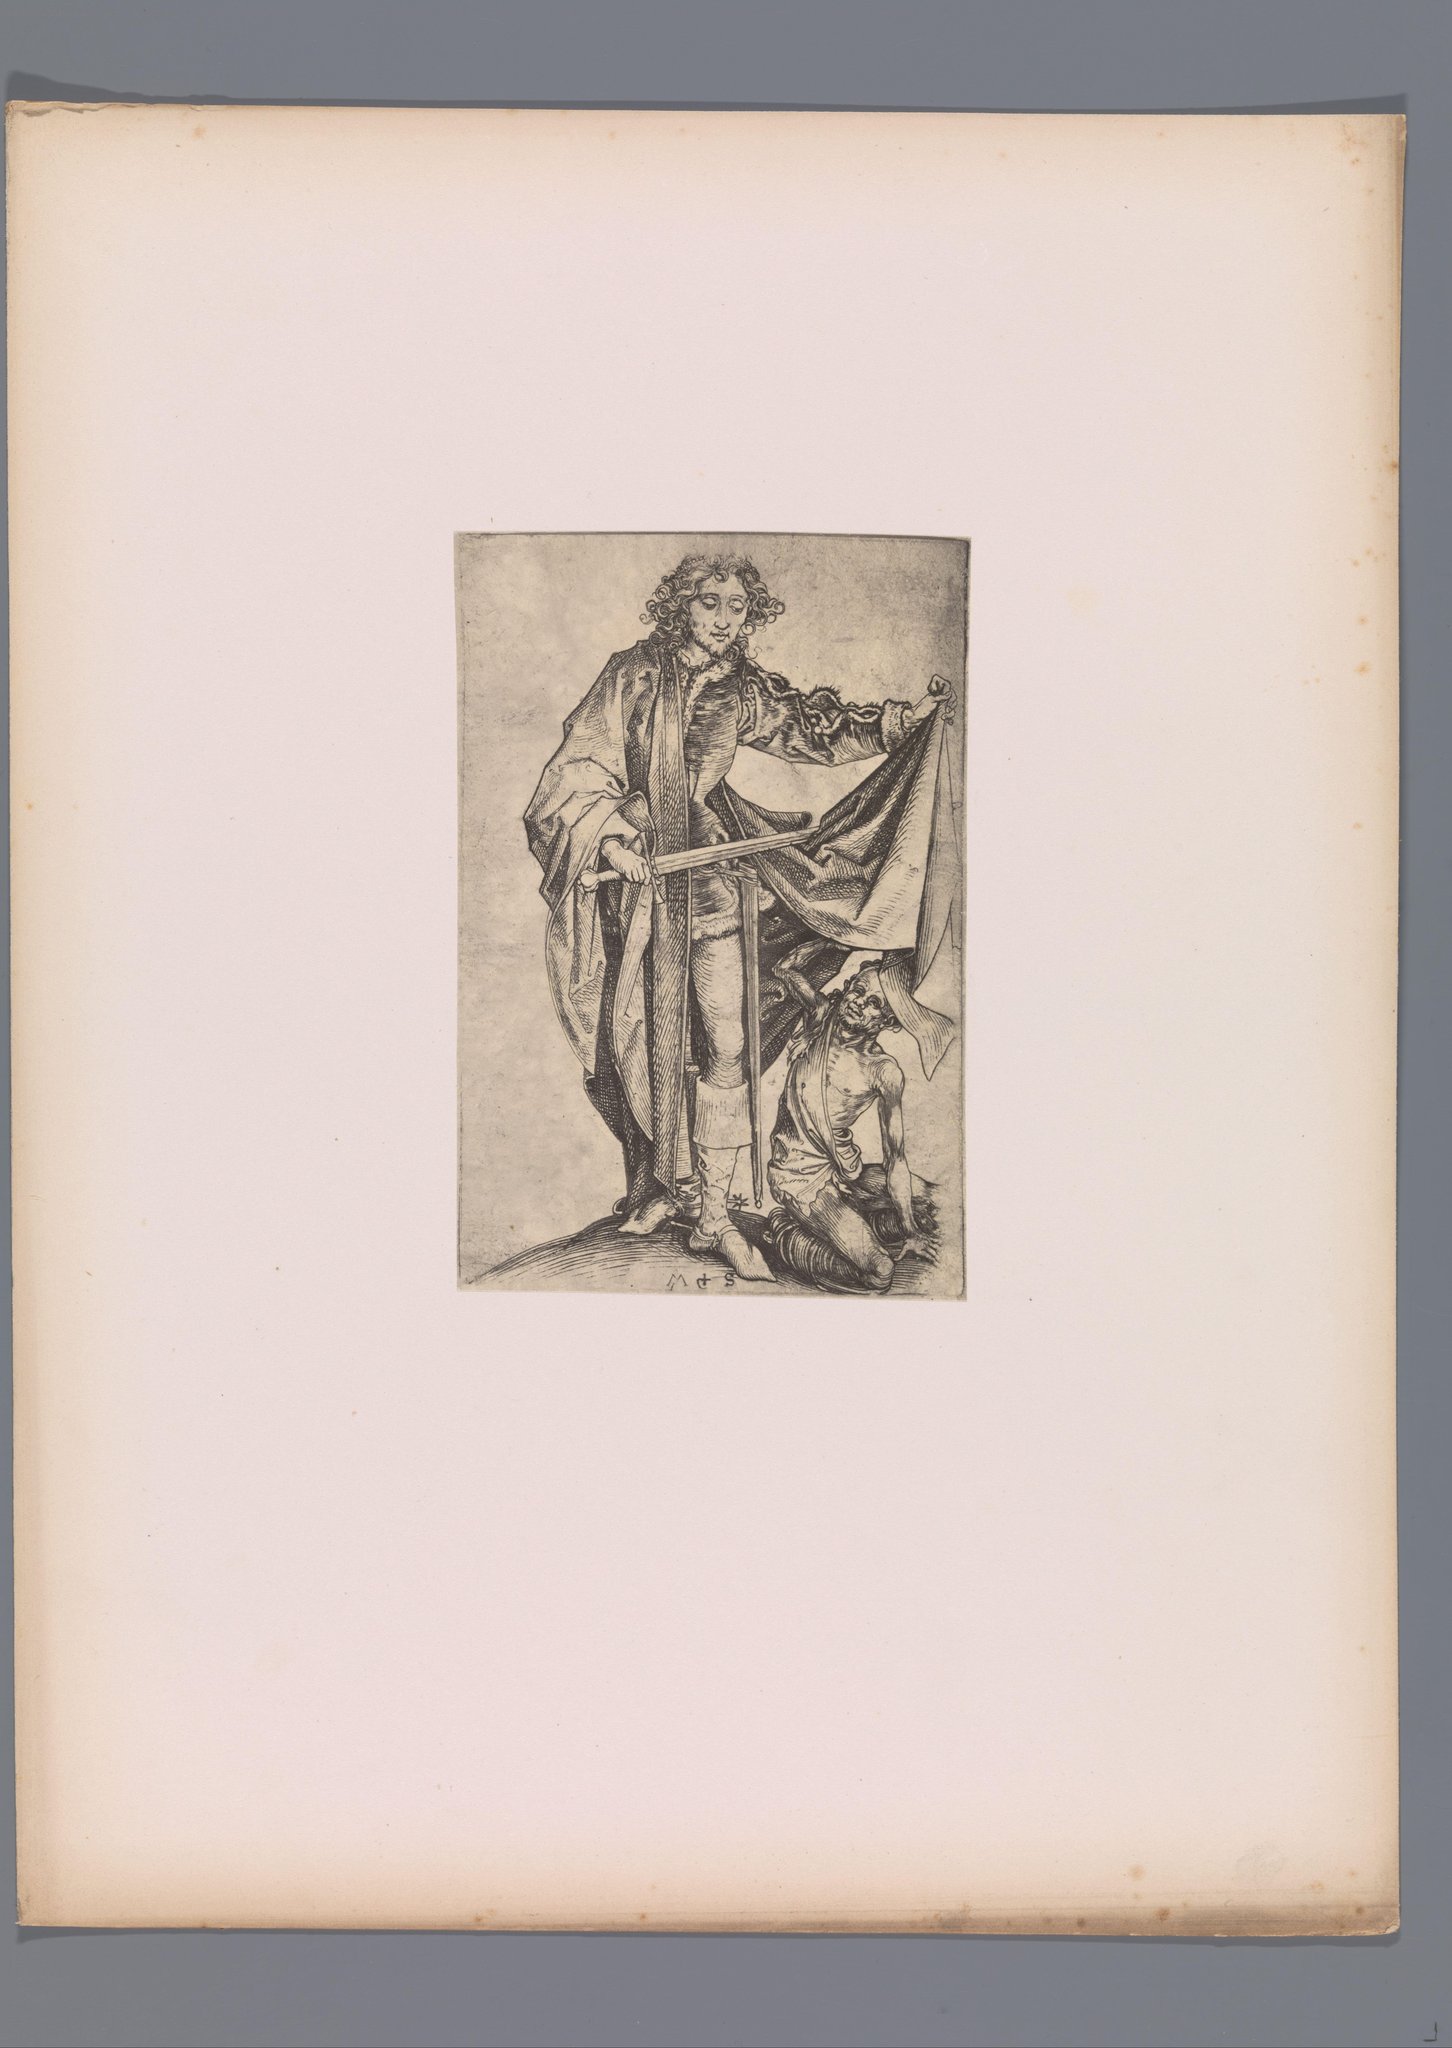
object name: reproduction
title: Reproductie van een prent van Sint Maarten door Martin Schongauer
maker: martin schongauer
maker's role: print maker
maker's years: 1430-1491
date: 1867-1872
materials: paper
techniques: woodburytype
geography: brussels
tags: martin(us), bishop of tours; possible attributes: beggar, goose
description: Deze prent maakt deel uit van een omslag met 24 prenten op 24 bladen.